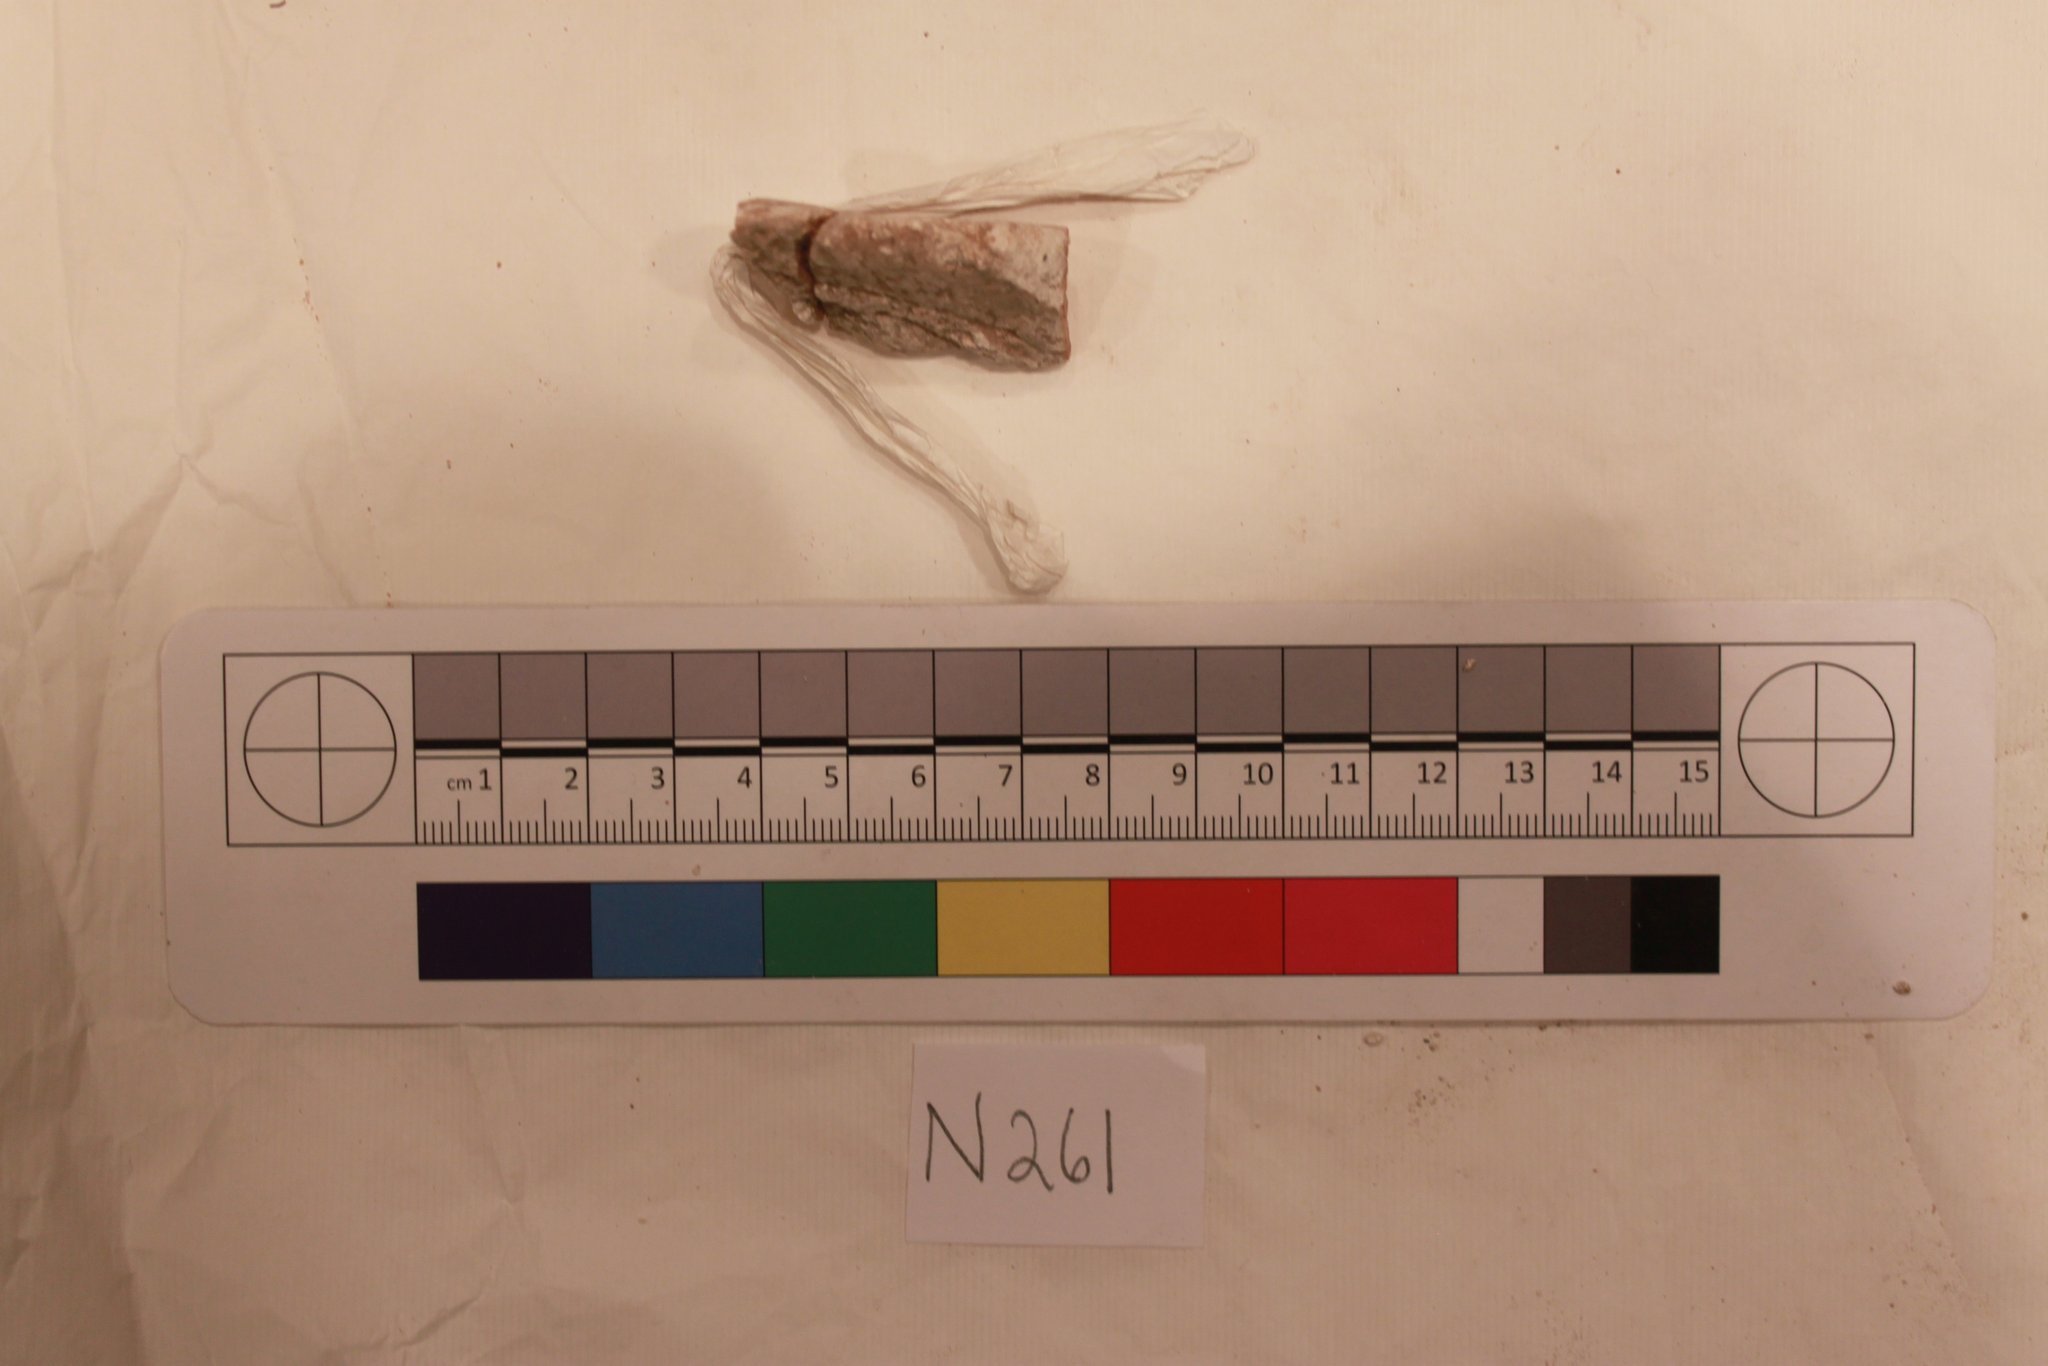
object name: fragment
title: Stucco Fragment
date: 701-1200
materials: plaster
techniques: carving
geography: iran